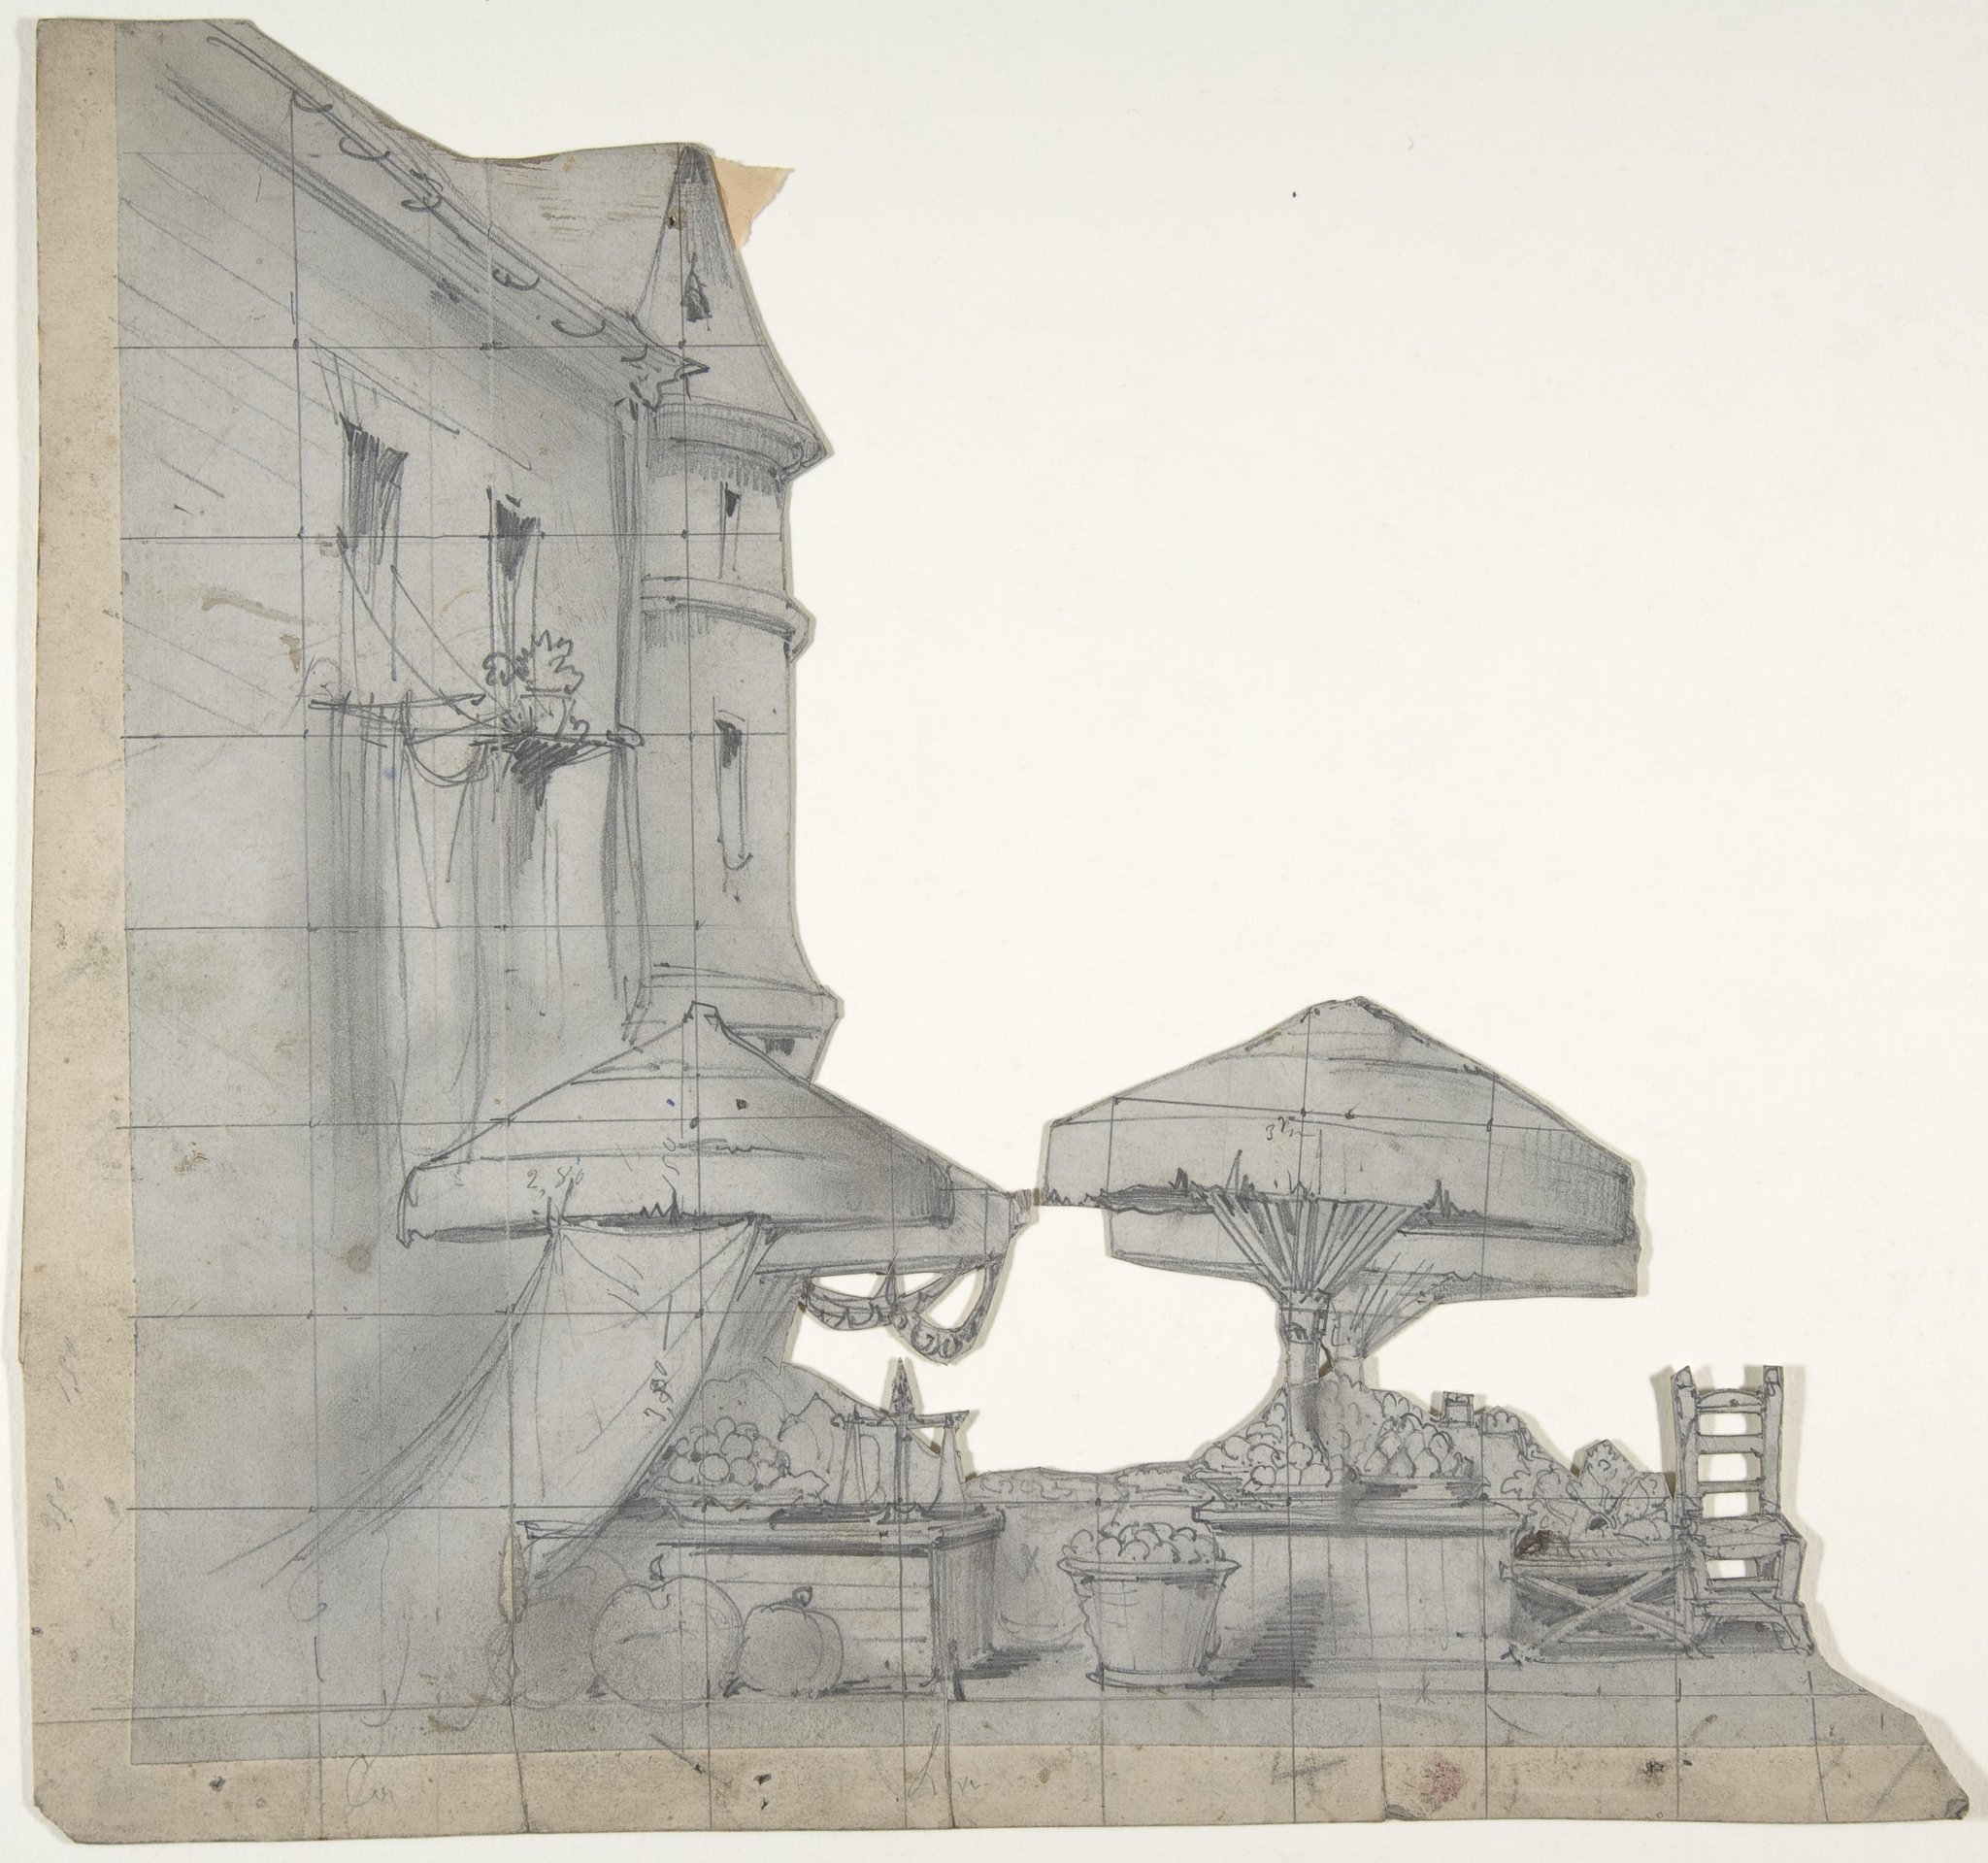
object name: drawing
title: Design for a Stage Set at the Opéra, Paris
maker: eugène cicéri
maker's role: artist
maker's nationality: french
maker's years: 1813-1890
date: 1830-1890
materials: graphite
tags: stage design